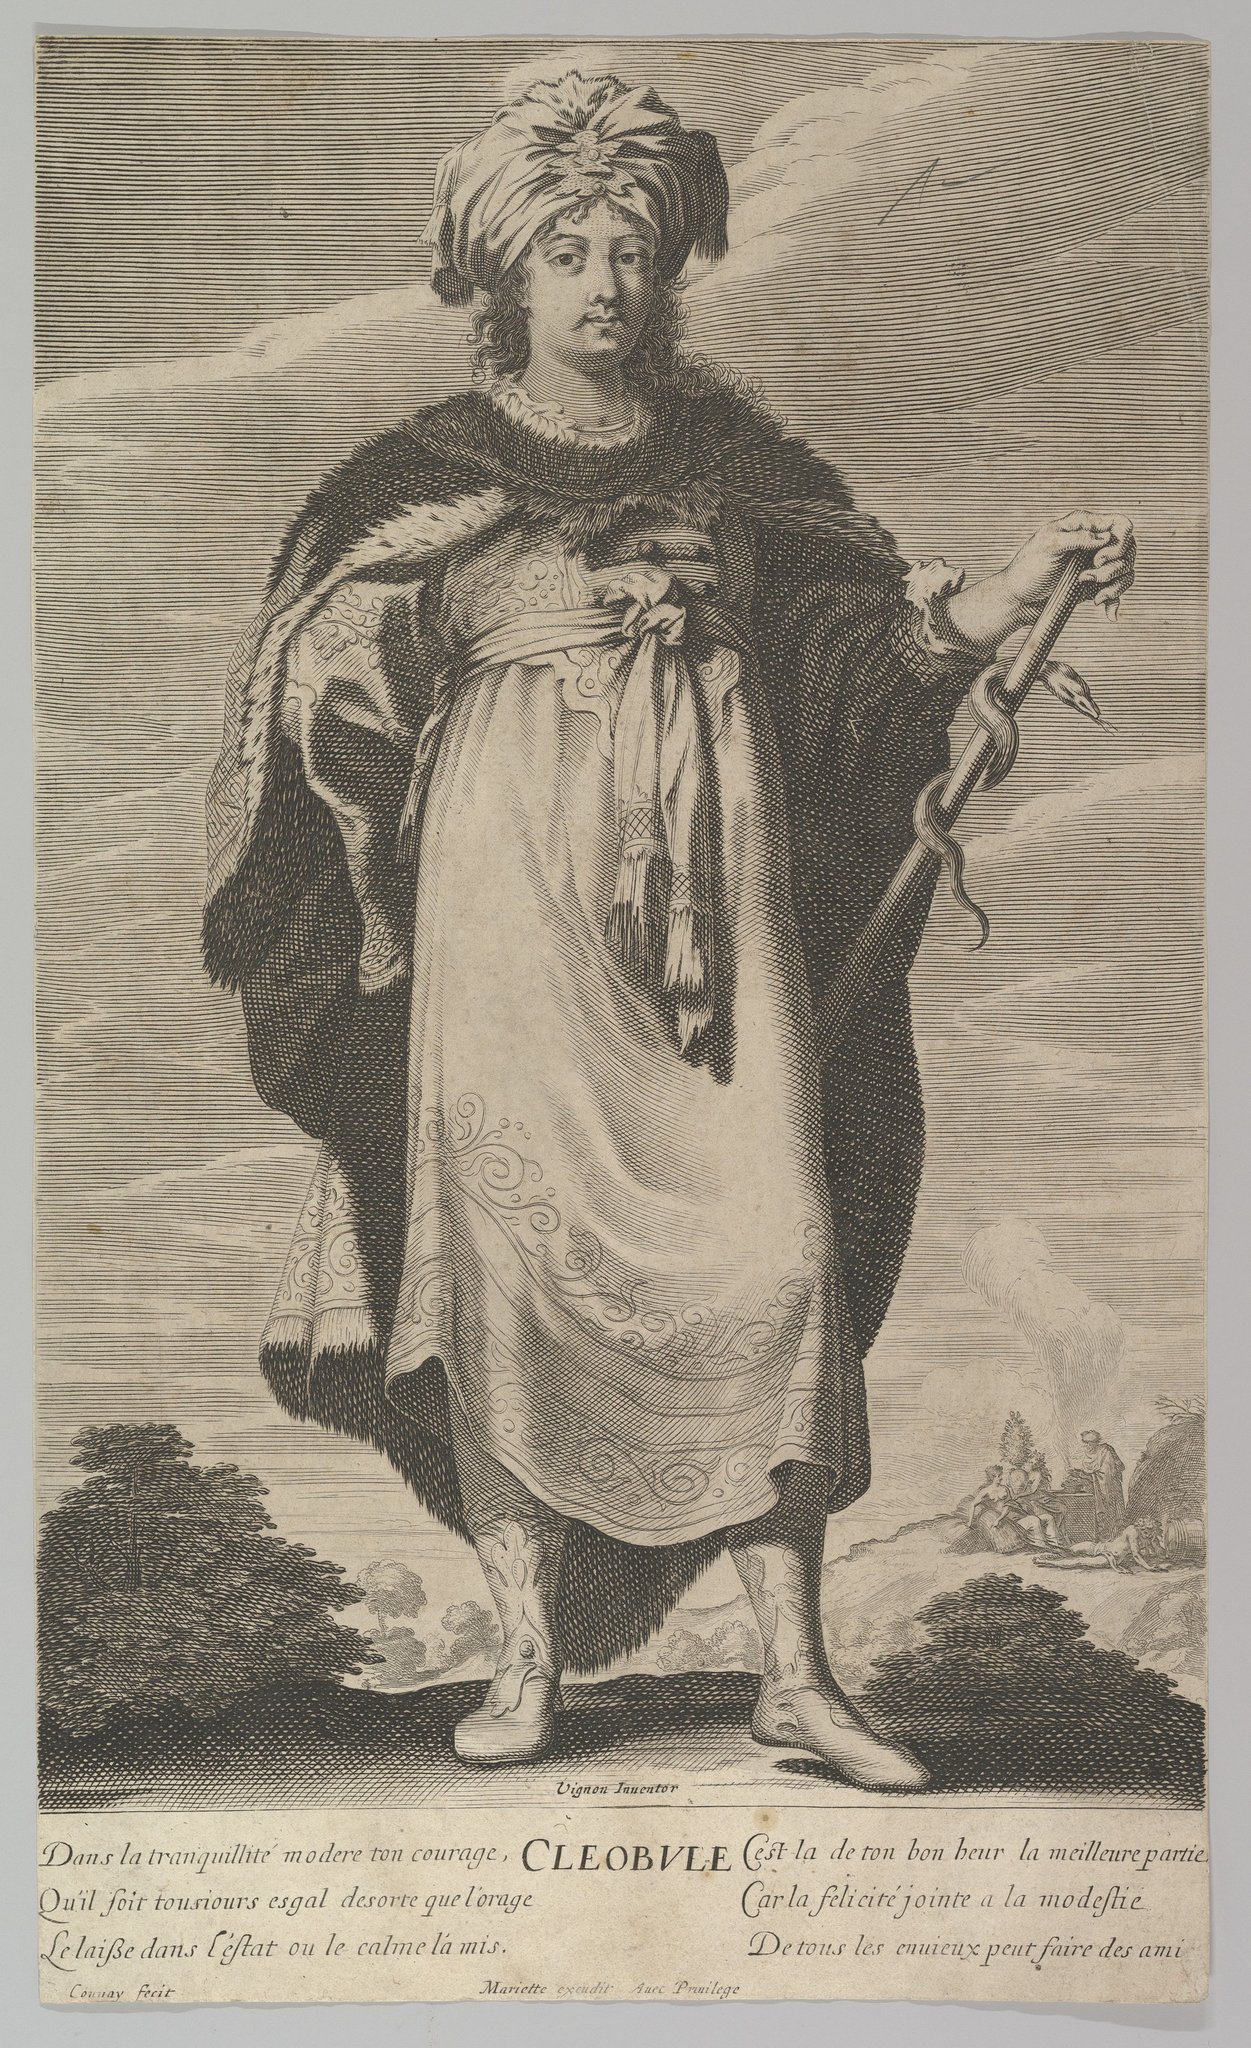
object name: print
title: Cléobule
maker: jean couvay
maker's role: artist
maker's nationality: french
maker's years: 1600-1663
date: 1639-1640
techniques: engraving, etching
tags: men,portraits